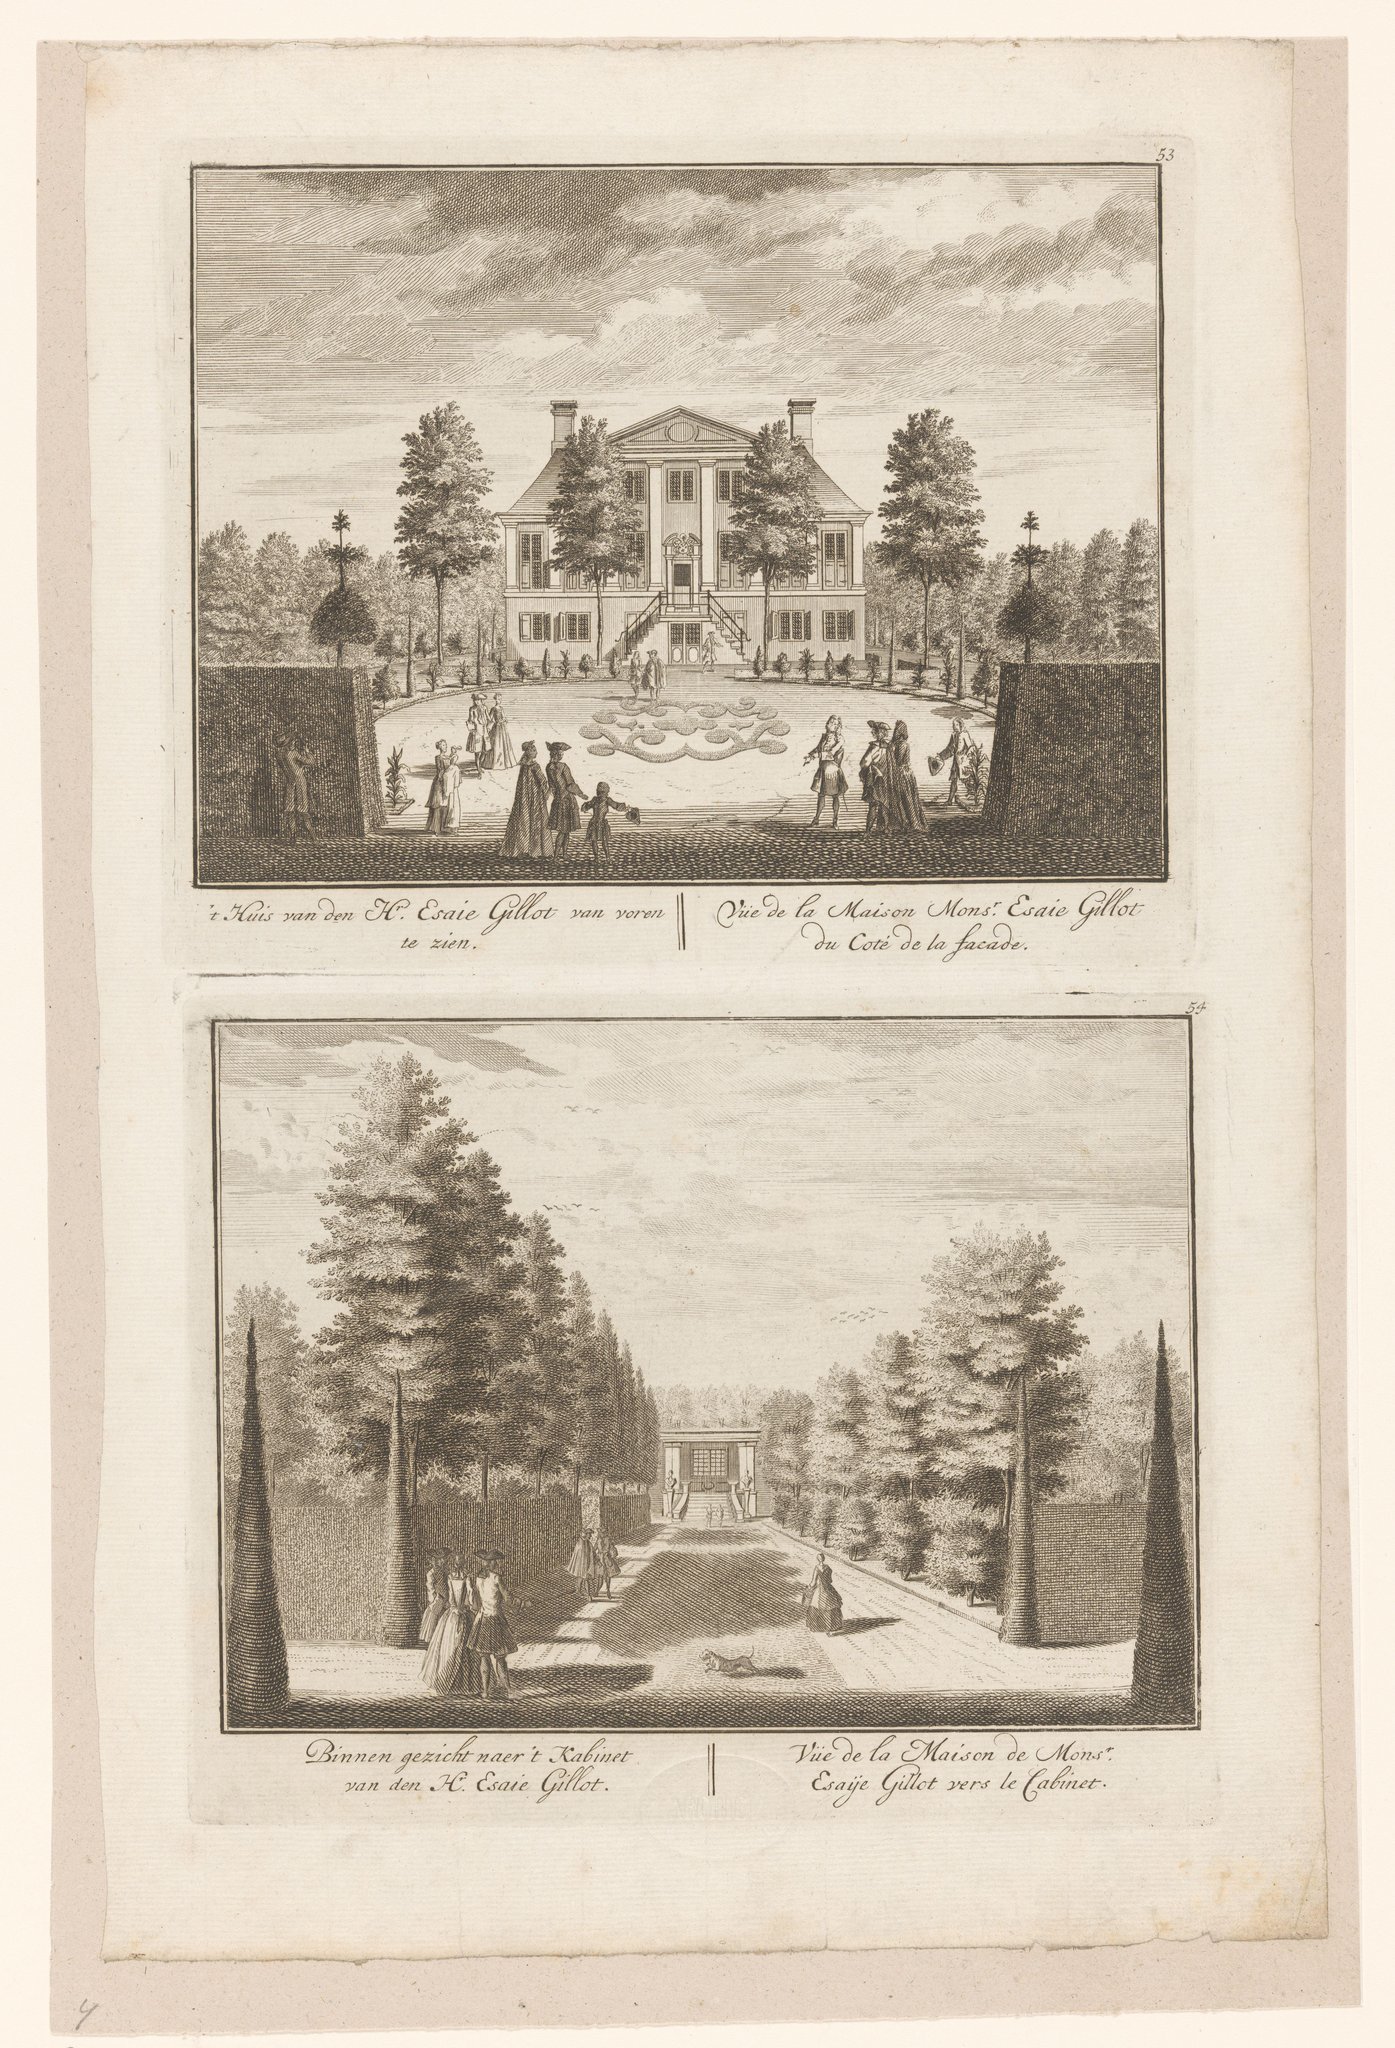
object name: book illustration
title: Binnen gezicht naer 't kabinet van den hr. Esaie Gillot / Vüe de la maison de monr. Esaije Gillot vers le cabinet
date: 1725-1768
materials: paper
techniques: engraving, etching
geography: amsterdam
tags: french or architectonic garden; formal garden, country-house, amsterdam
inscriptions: check stamp: ‘Archief Ministerie van Oorlog Afdeeling Genie’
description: Prent gebruikt in: Niedek, Mattaeus Brouërius. Het verheerlykt Watergraafs- of Diemermeer by de stadt Amsterdam (...). Amsterdam: Andries en Hendrik de Leth, 1725. Of in: Niedek, Mattaeus Brouërius. Het verheerlykt Watergraafs- of Diemermeer by de stadt Amsterdam (...). Amsterdam: Pieter Jan Entrop, 1768.